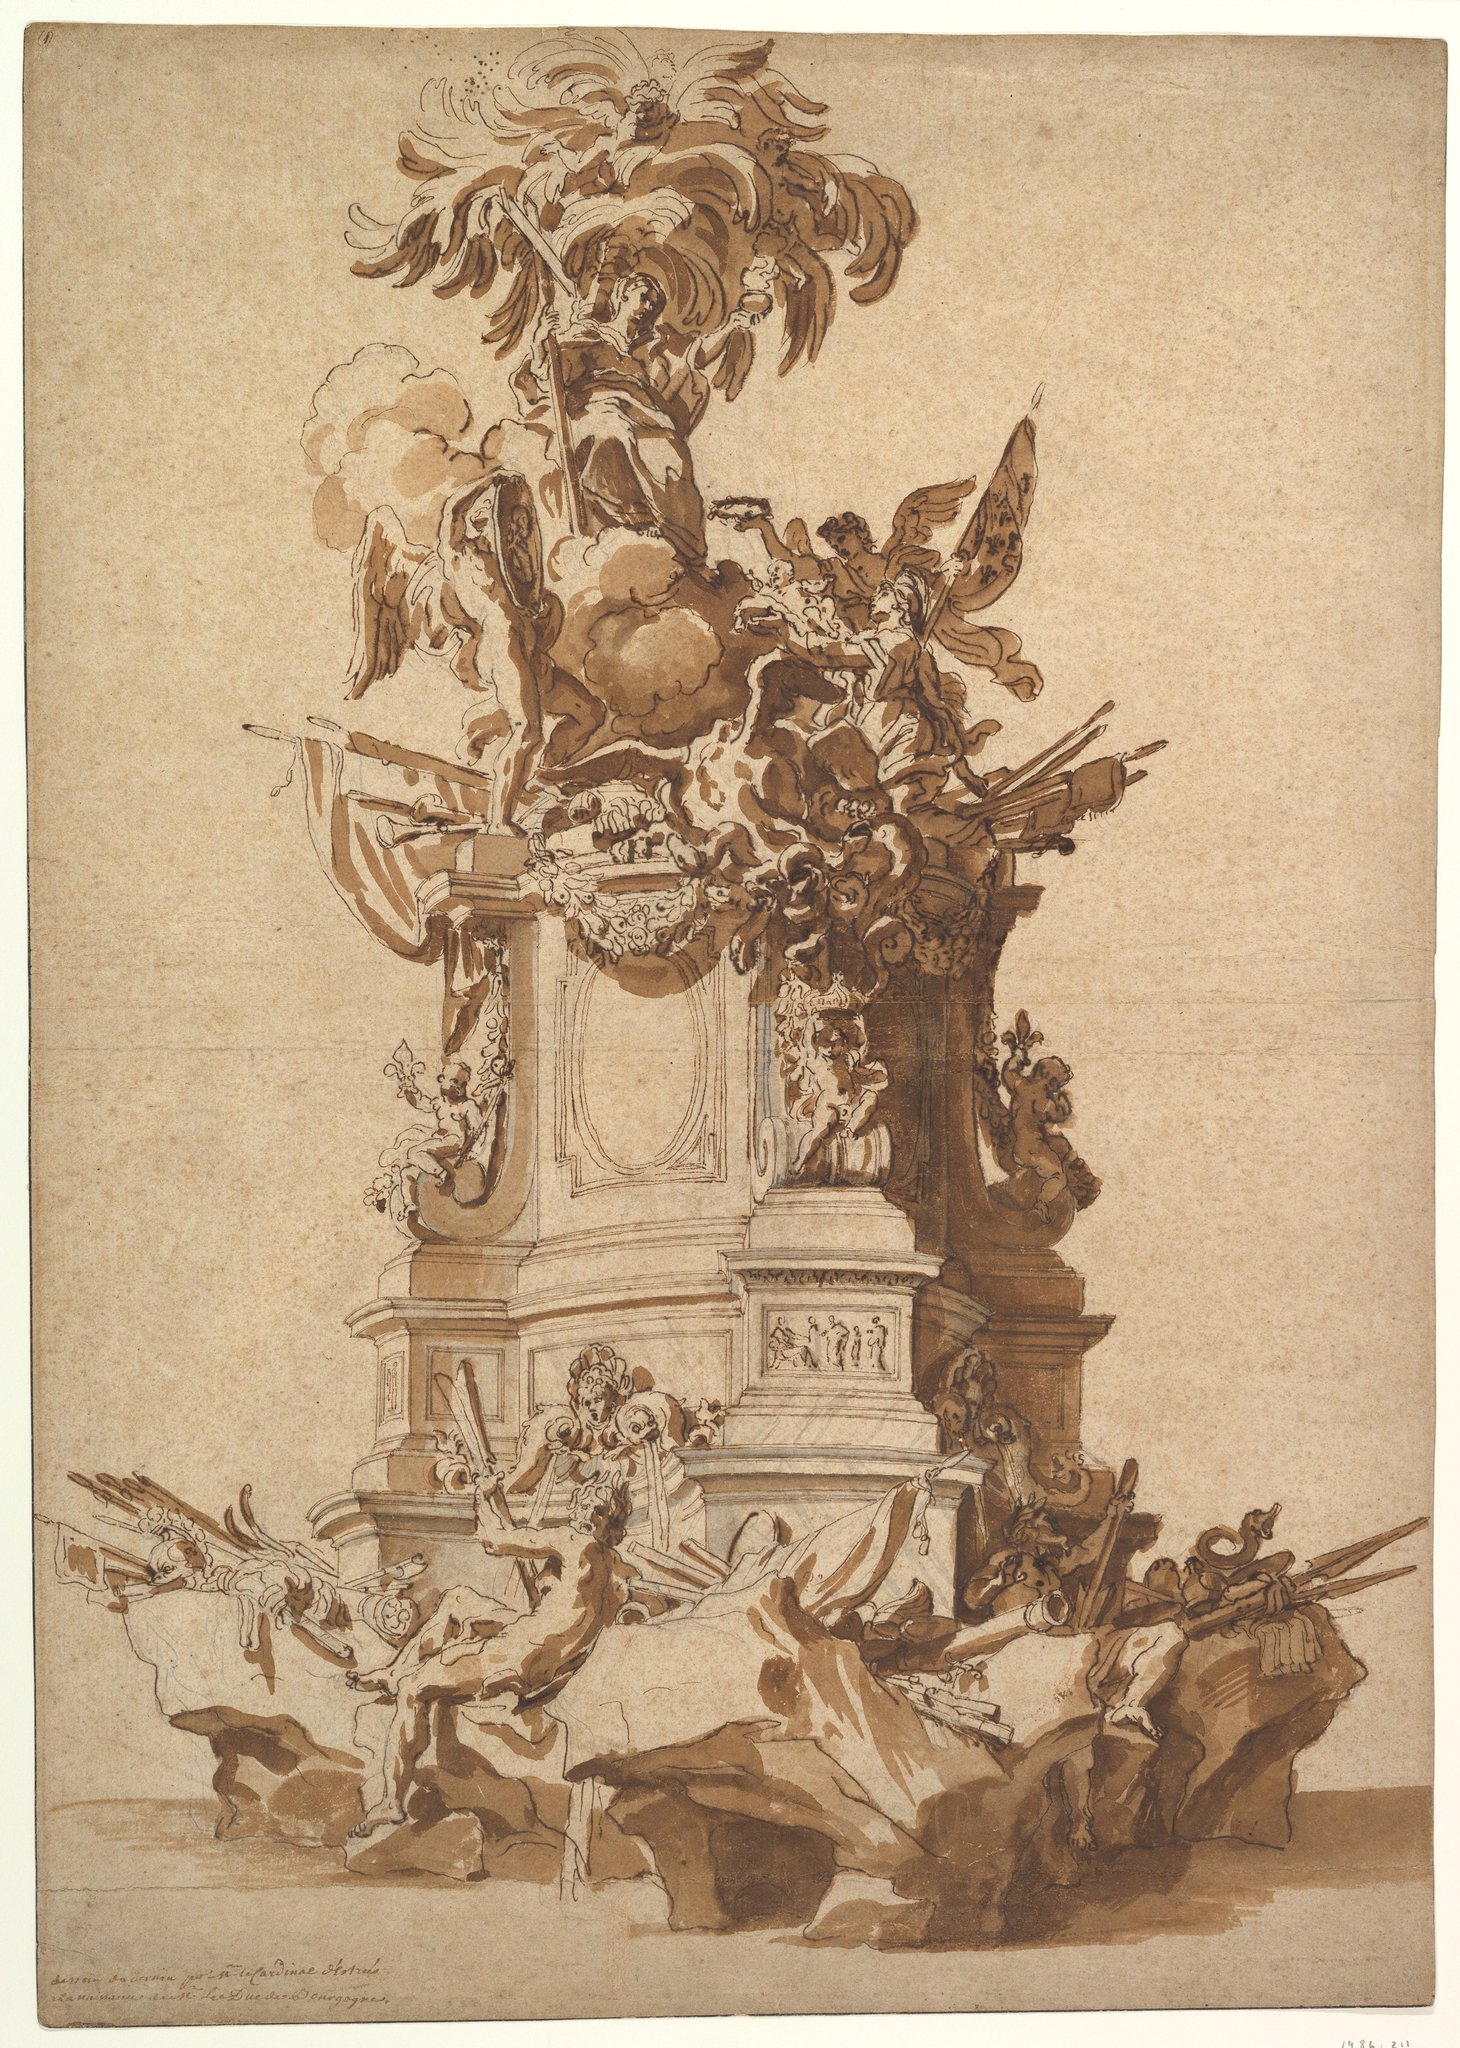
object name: drawing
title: Temporary Structure in Celebration of the Birth of the Duc de Bourgogne (August 6, 1682)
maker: anonymous, italian, roman-bolognese, 17th century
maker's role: artist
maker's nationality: italian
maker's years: 1600-1700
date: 1650-1700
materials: chalk, graphite, ink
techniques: brush, pen, wash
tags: male nudes,women